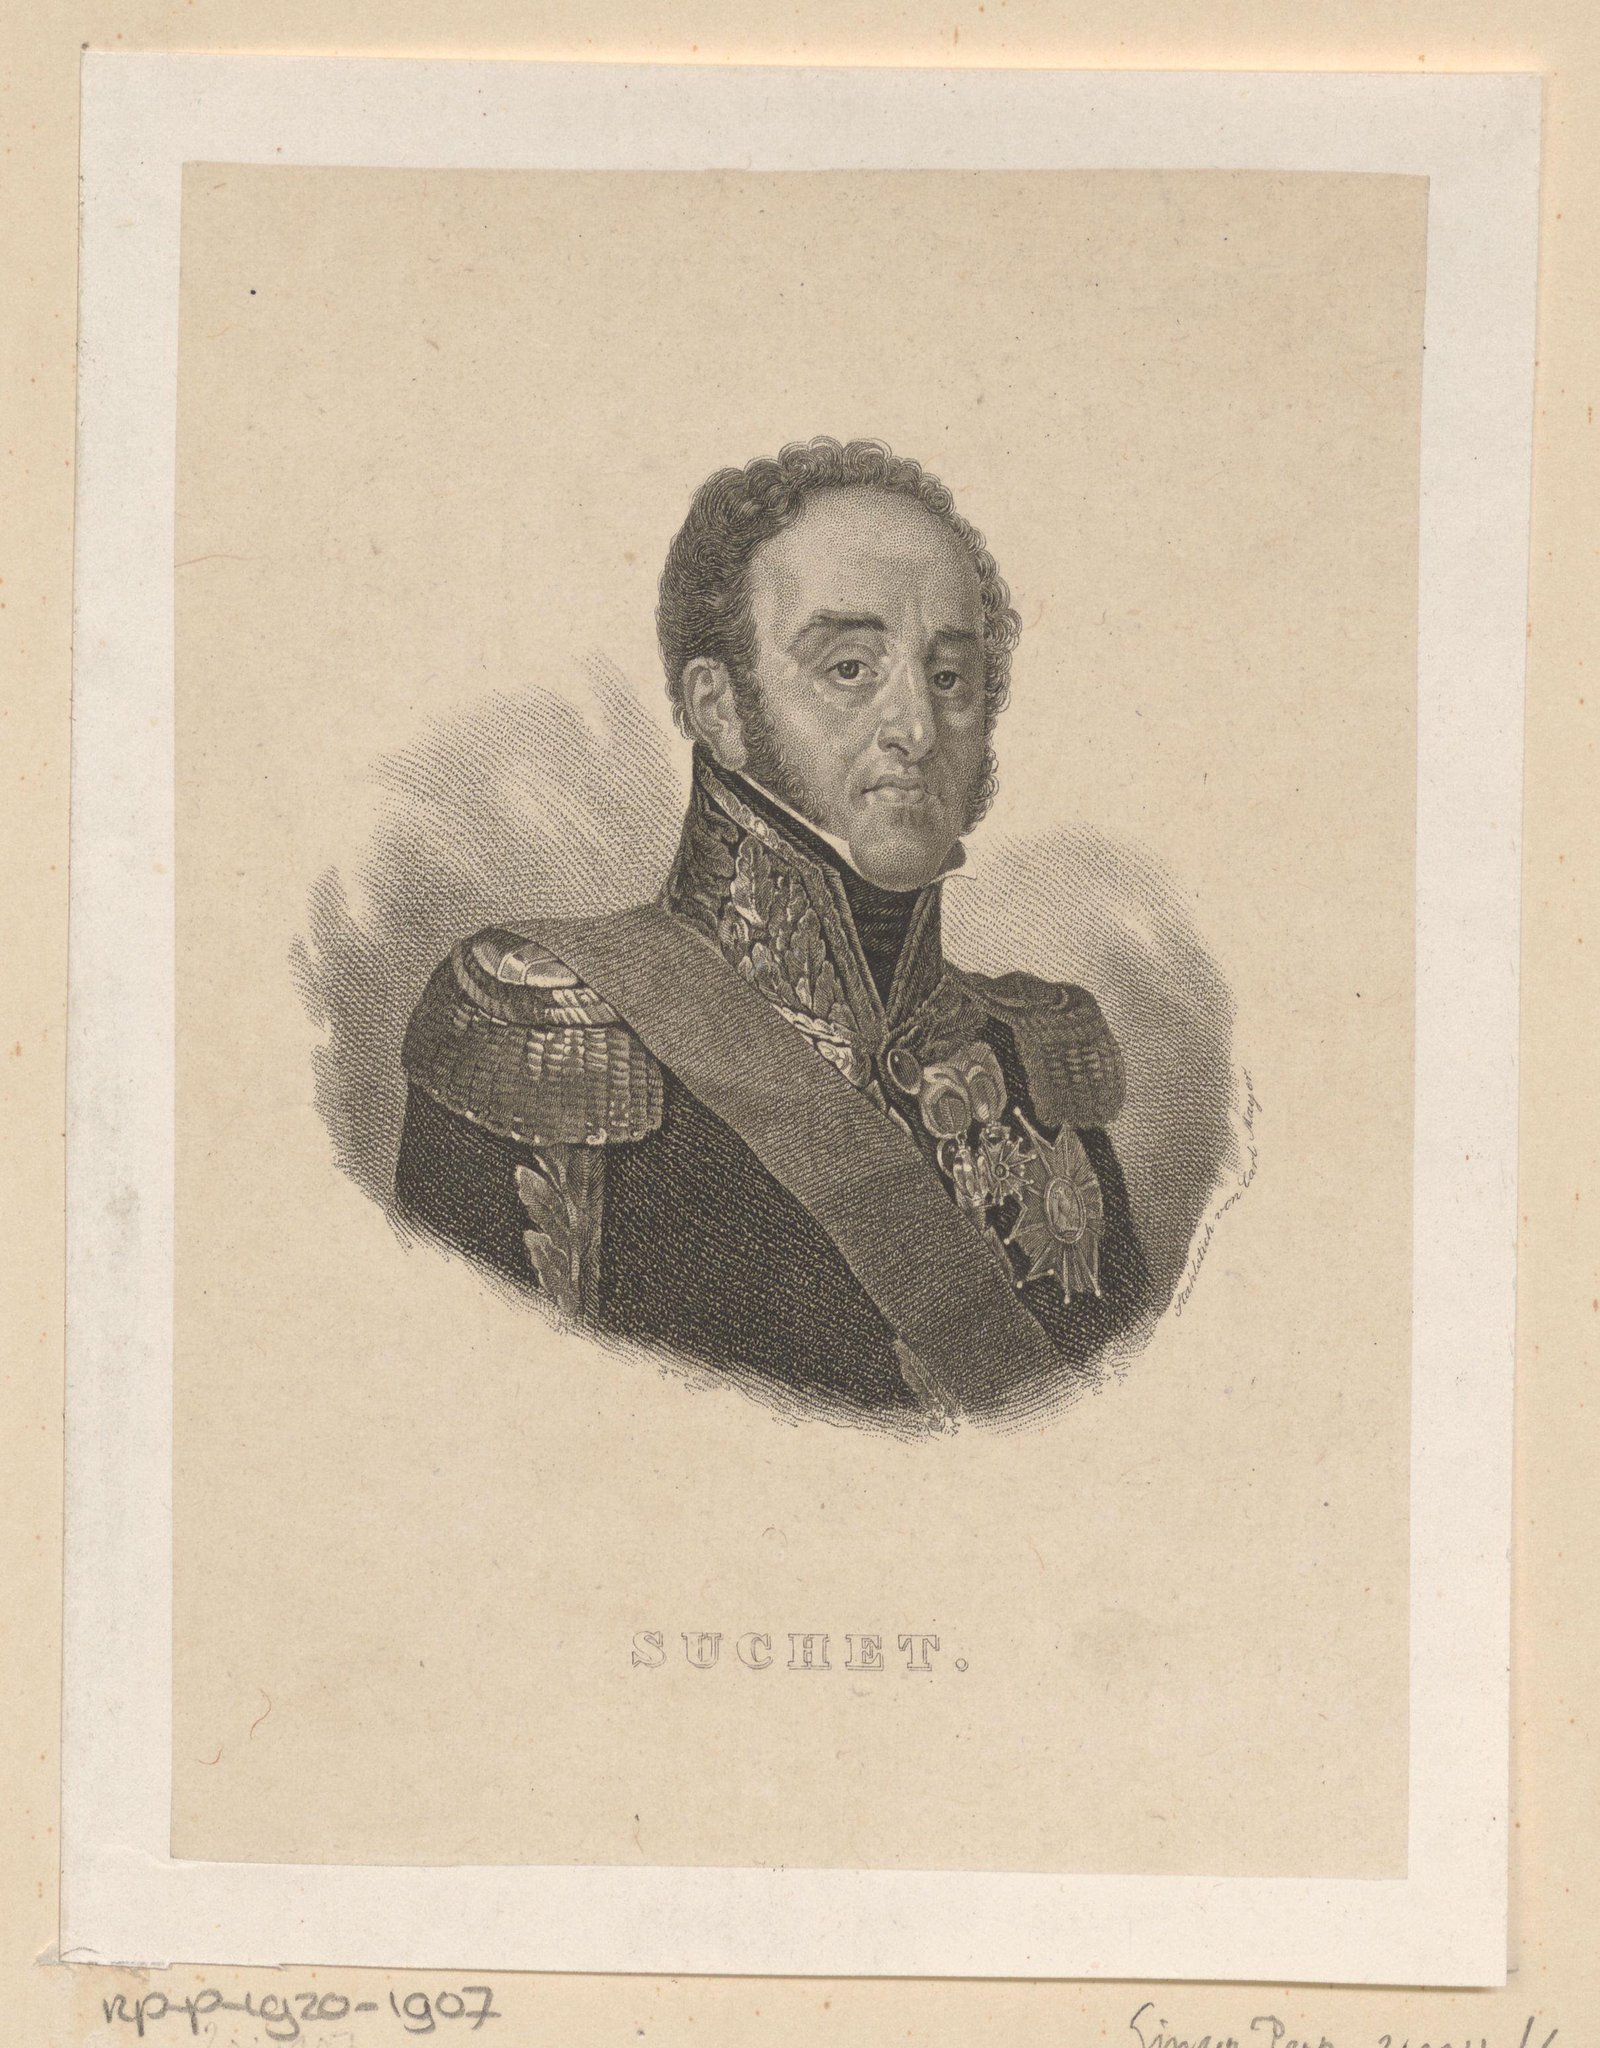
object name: print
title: Portret van Louis-Gabriel Suchet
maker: carl mayer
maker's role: print maker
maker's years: 1798-1868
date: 1820-1868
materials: paper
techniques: engraving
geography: nuremberg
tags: lyon, marseille, commander-in-chief, general, marshal, historical persons, medals and other marks of military honour, (military) uniforms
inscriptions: collector's mark: Lugt 2228